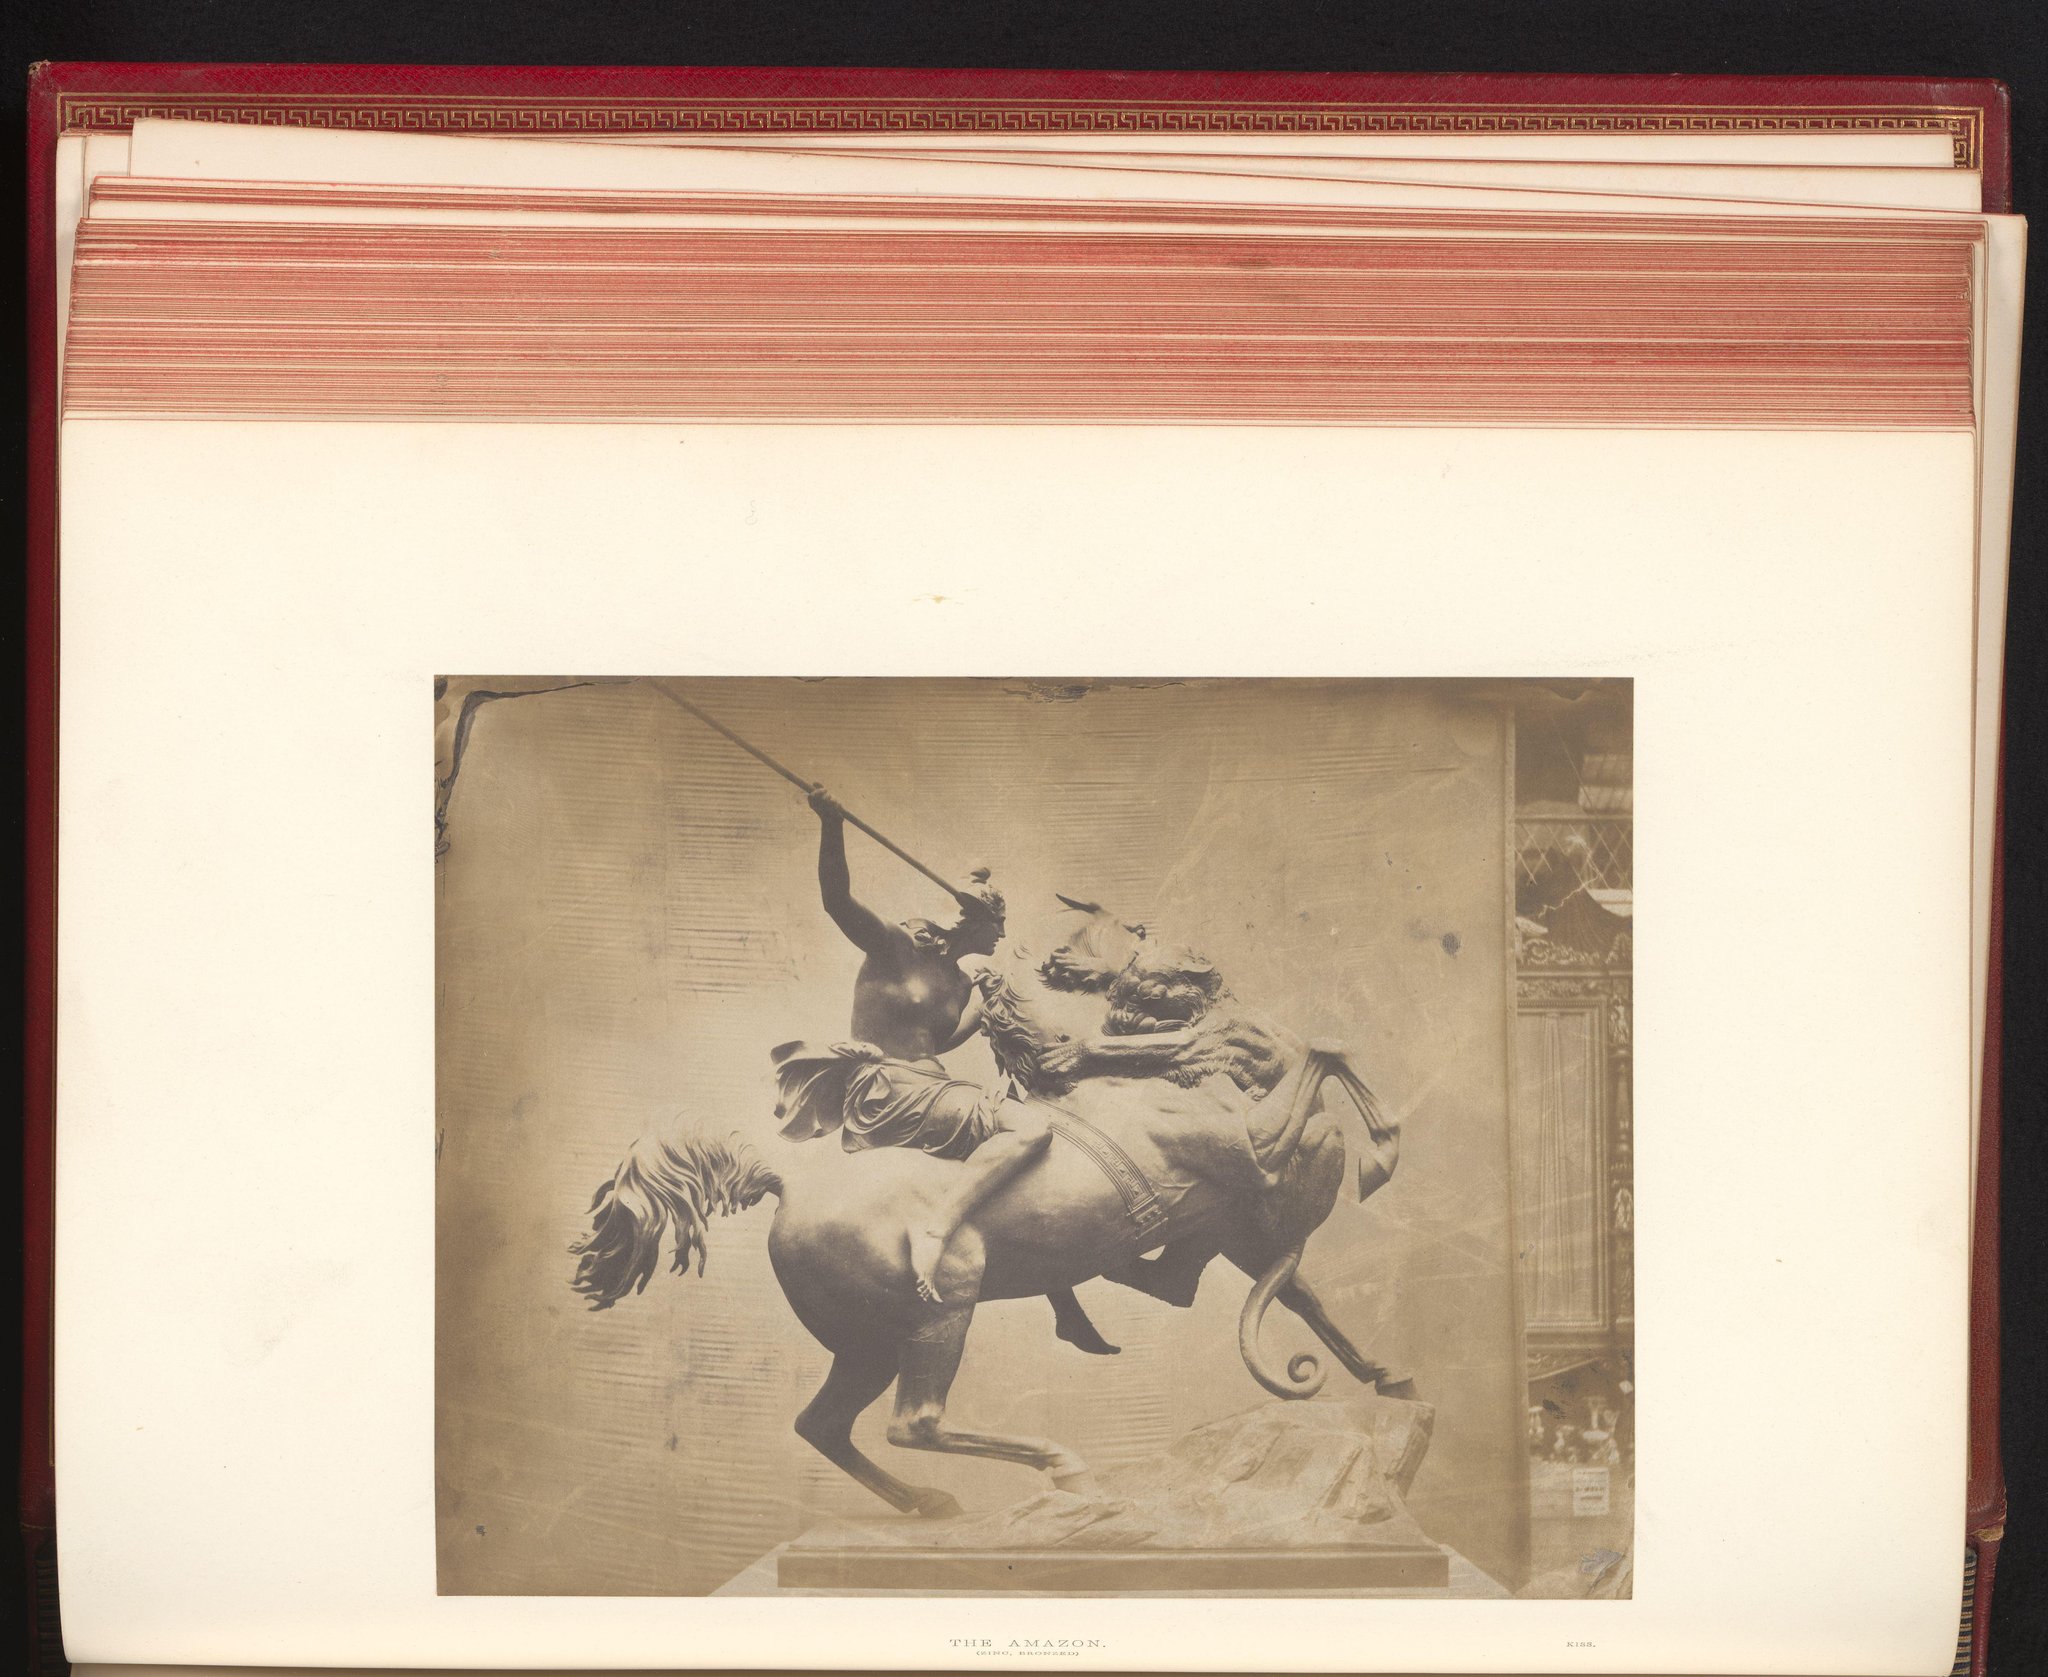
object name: photograph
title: The Amazon. (Zinc, Bronzed) Kiss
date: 1851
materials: photographic support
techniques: salted paper print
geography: london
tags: (story of) the amazons, london